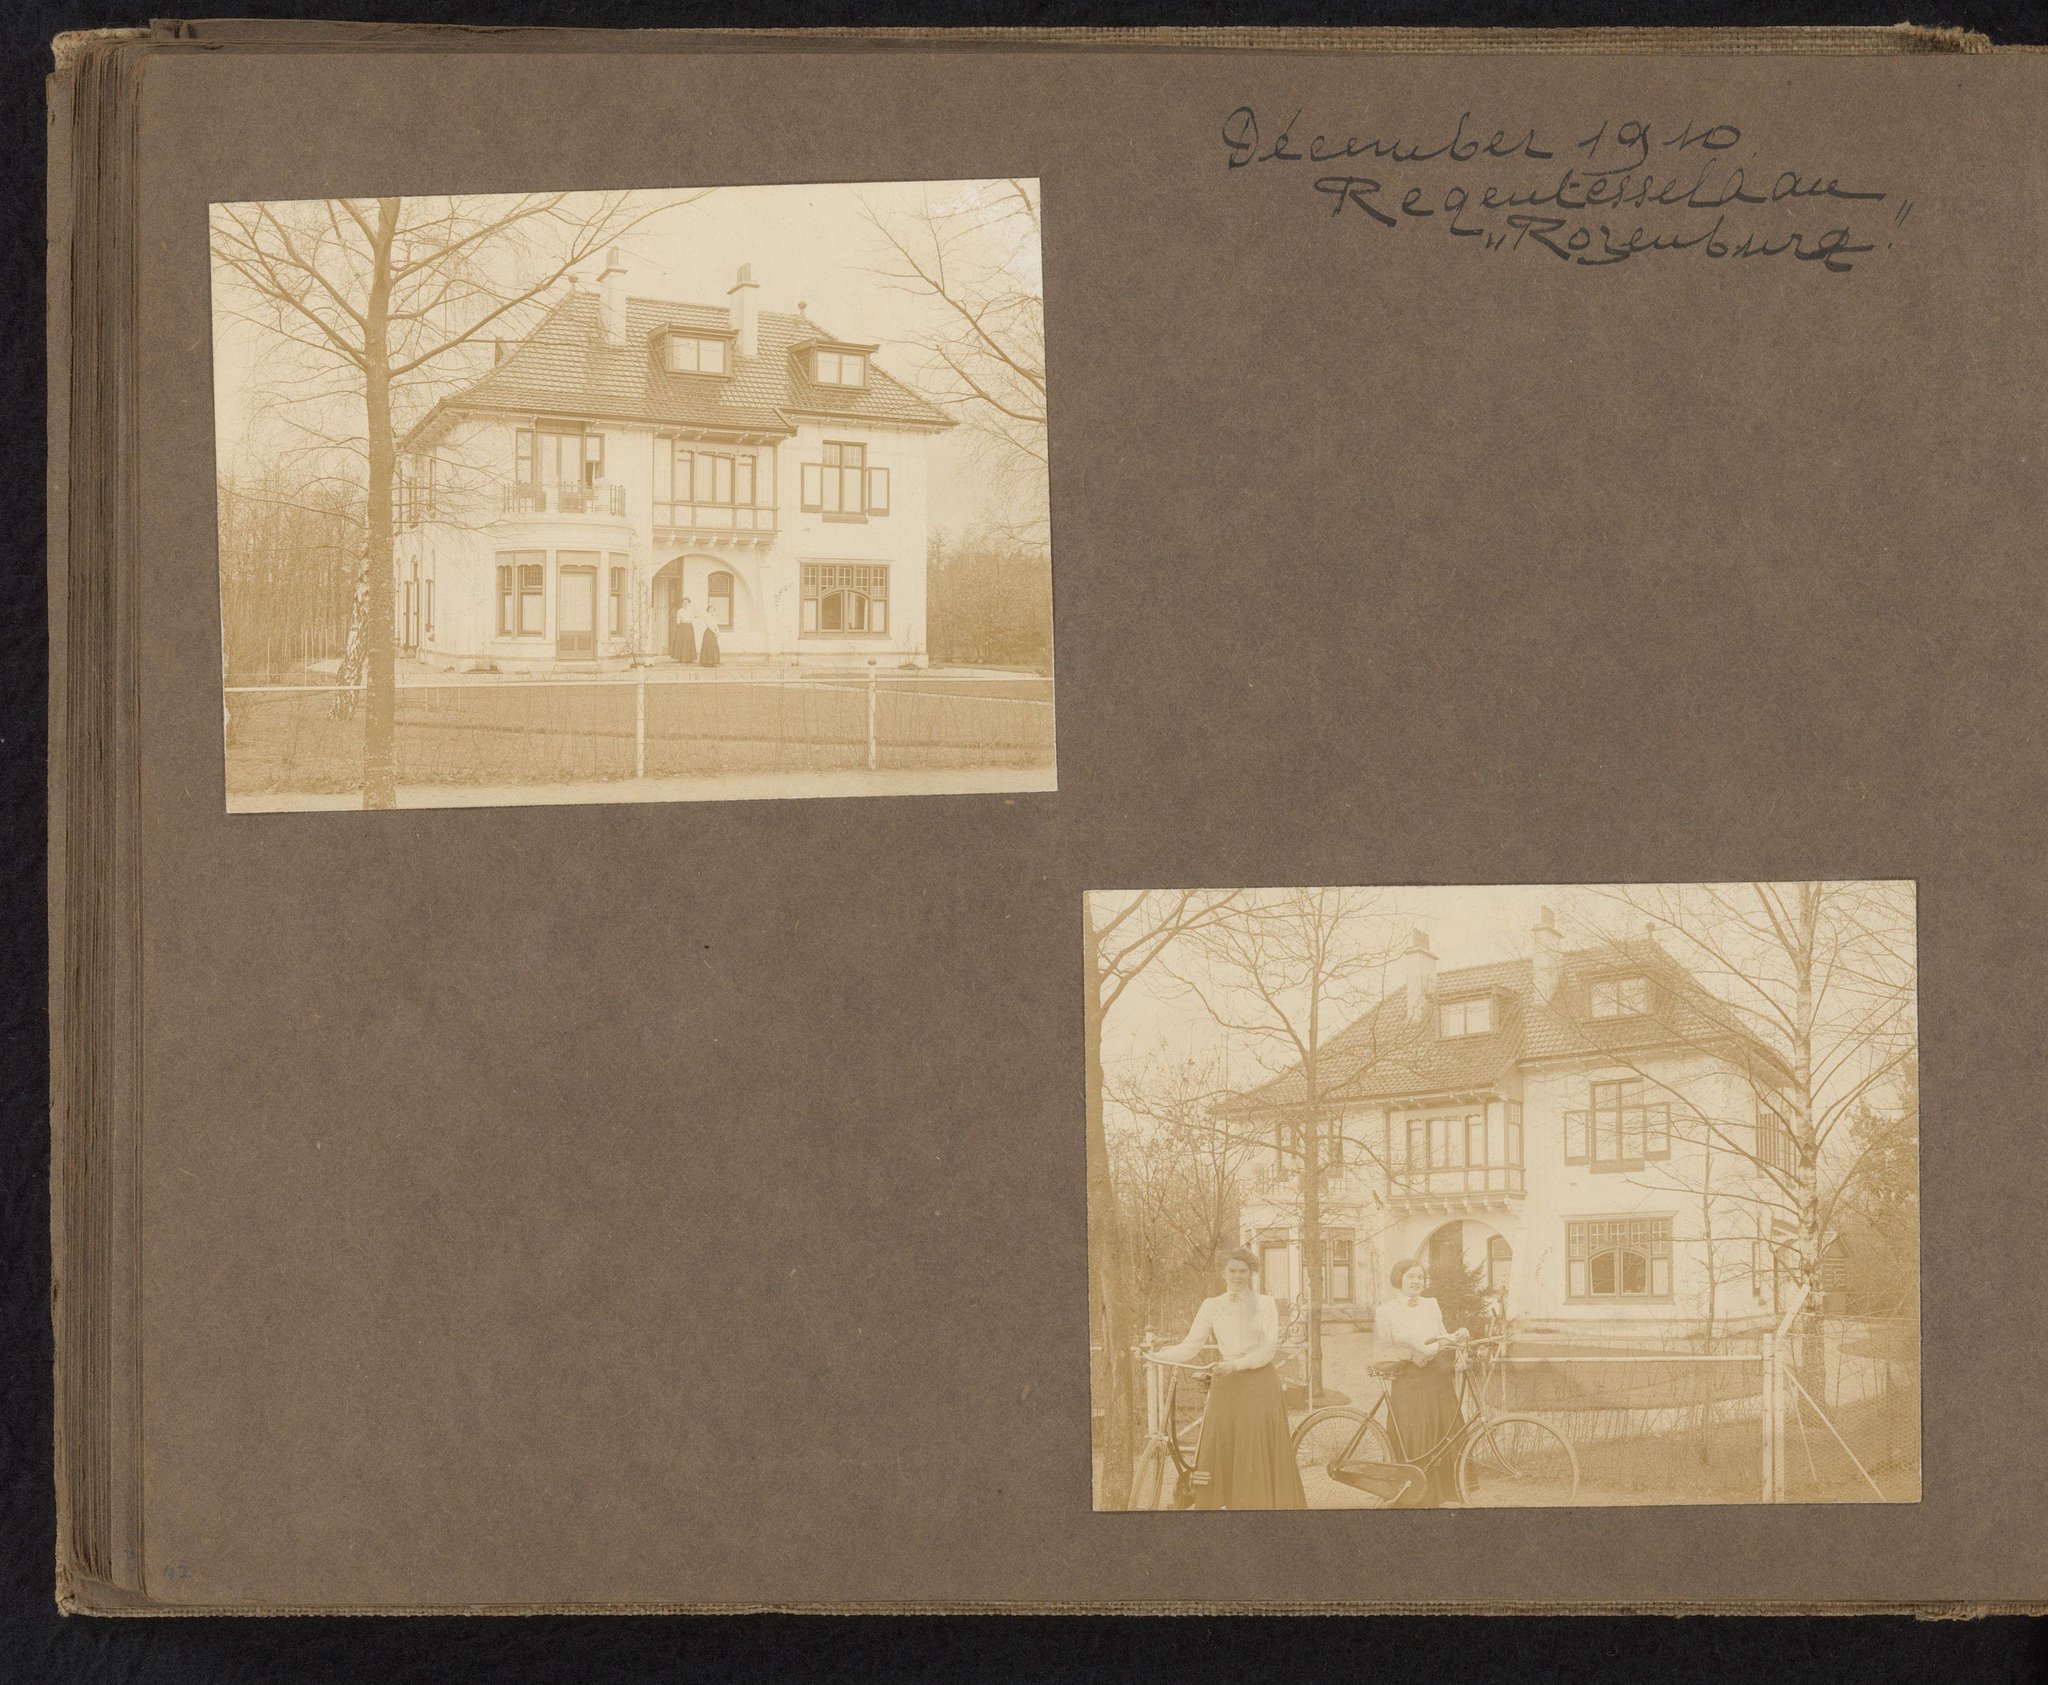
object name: album leaf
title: Décember 1910 Regentesselaan "Rozenburg"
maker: carolina frederika onnen (lien/loen)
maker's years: 1896-1983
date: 1910-1912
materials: paper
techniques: collodion silver print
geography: hilversum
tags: historical persons - bb - woman, villa, bicycle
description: Deze foto's maken deel uit van een album.